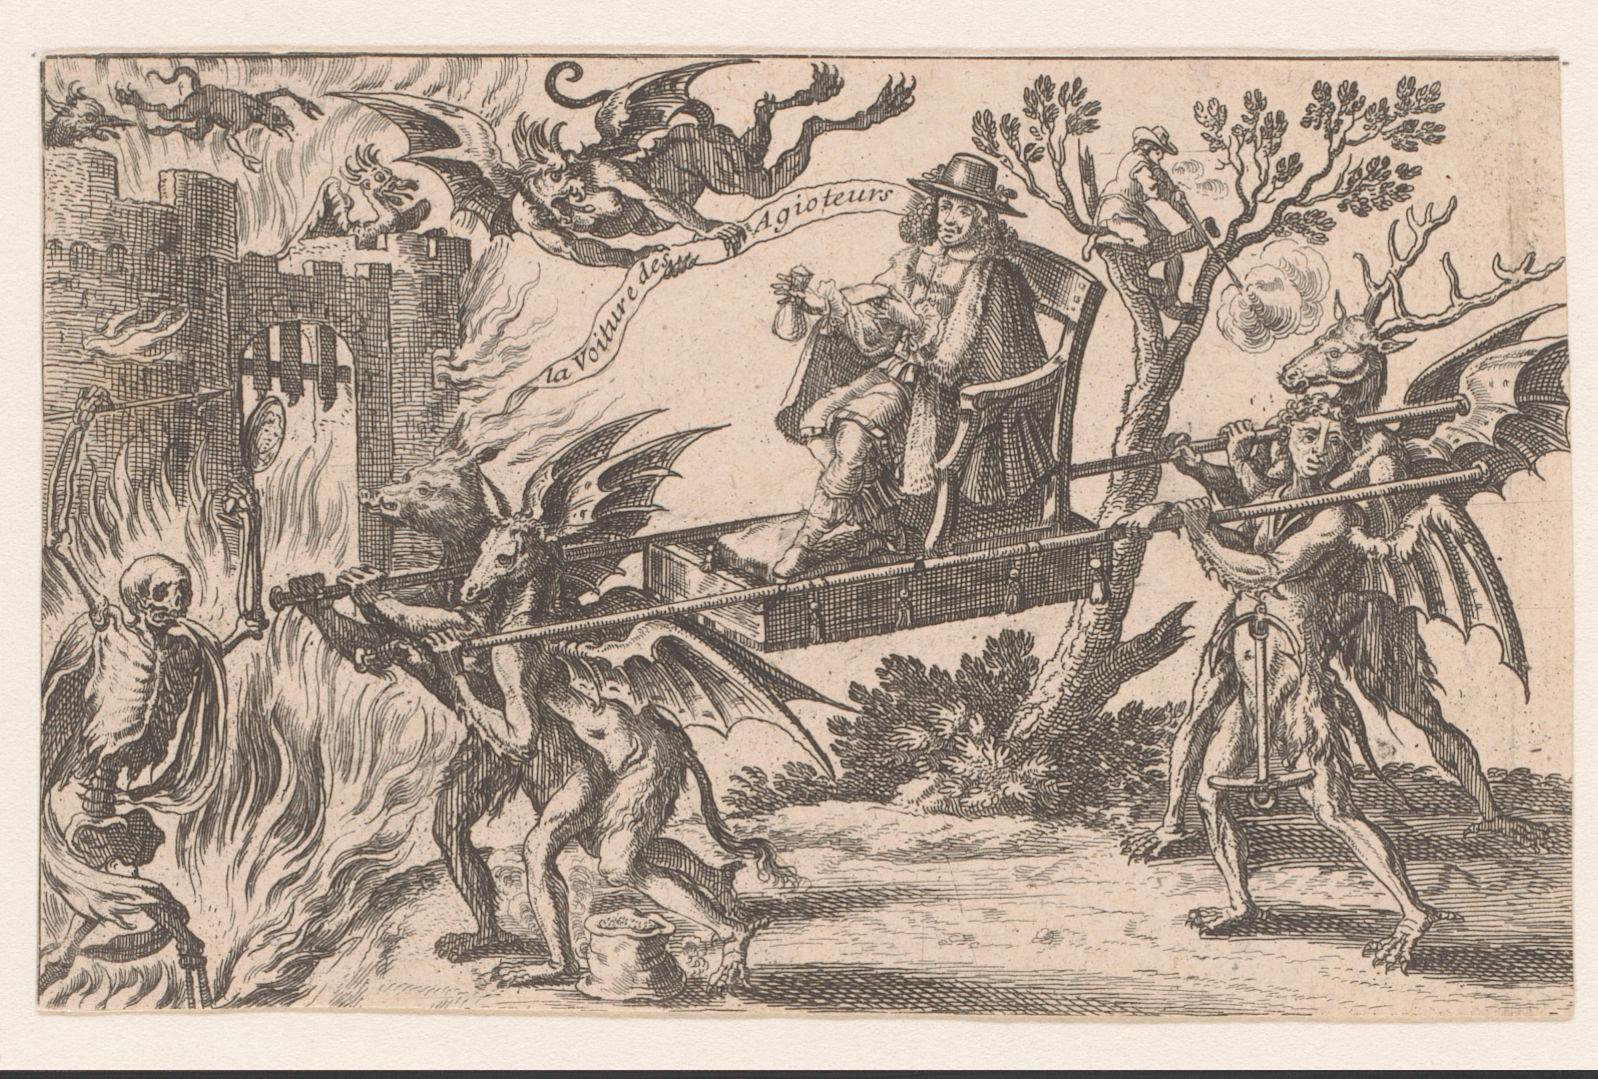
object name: print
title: Spotprent op de neergang van de South Sea Company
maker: Anonymous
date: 1701-1778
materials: paper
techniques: etching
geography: france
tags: speculative boom, devil(s) and demons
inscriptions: collector's mark: Lugt 240, inscription: ‘f22002’